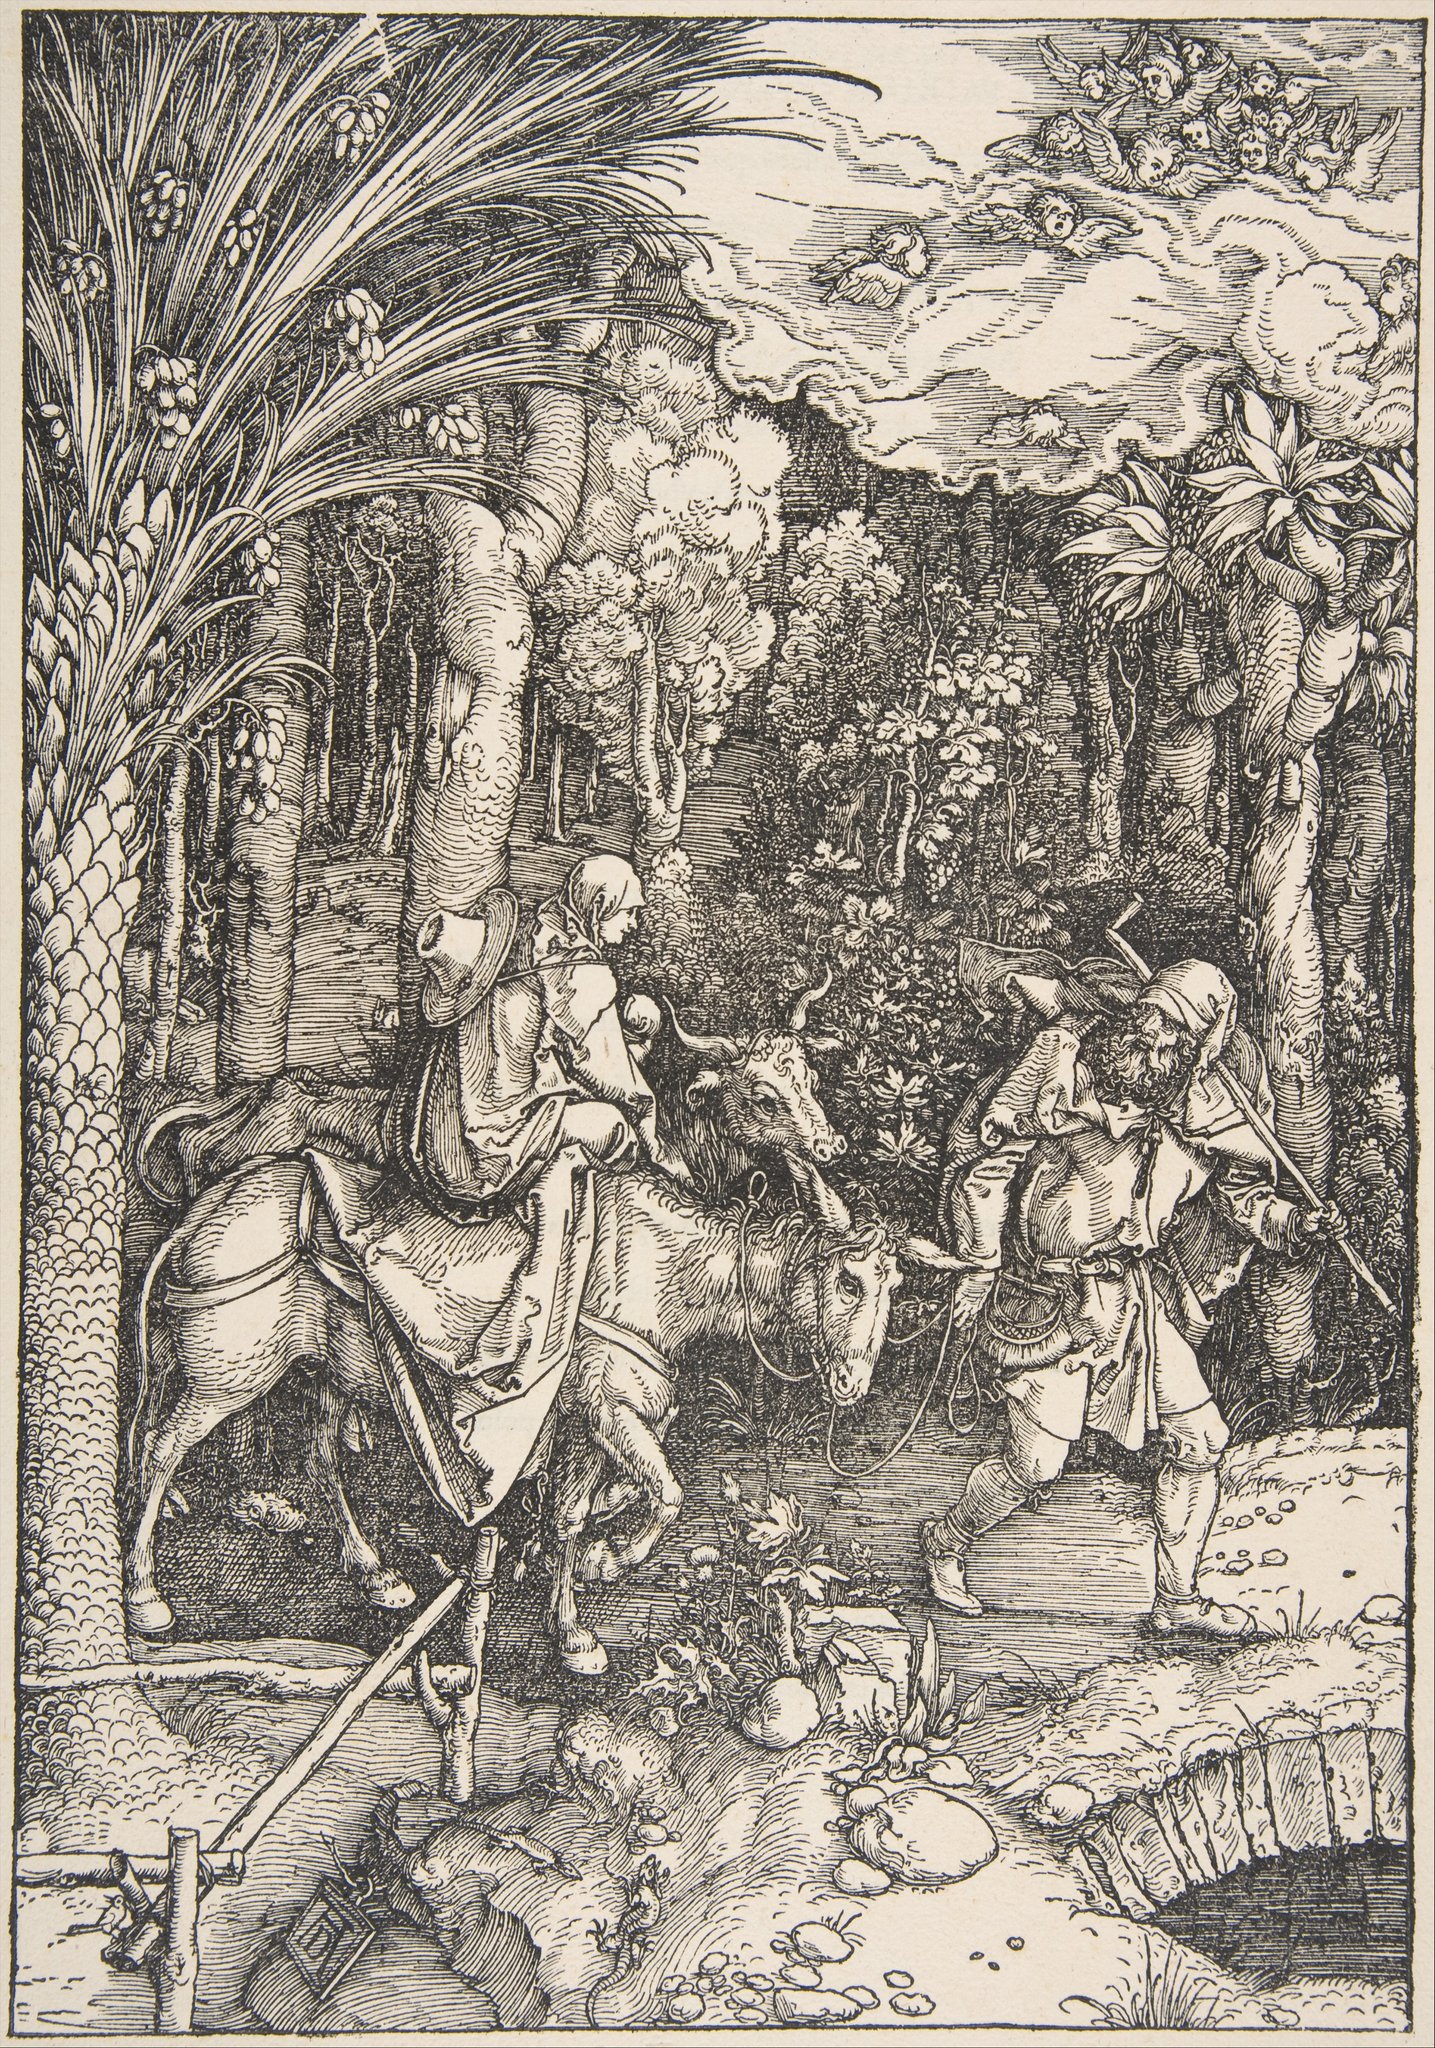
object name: print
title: The Flight into Egypt, from "The Life of the Virgin"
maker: albrecht dürer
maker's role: artist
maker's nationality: german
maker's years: 1471-1528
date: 1511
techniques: woodcut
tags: donkeys,flight into egypt